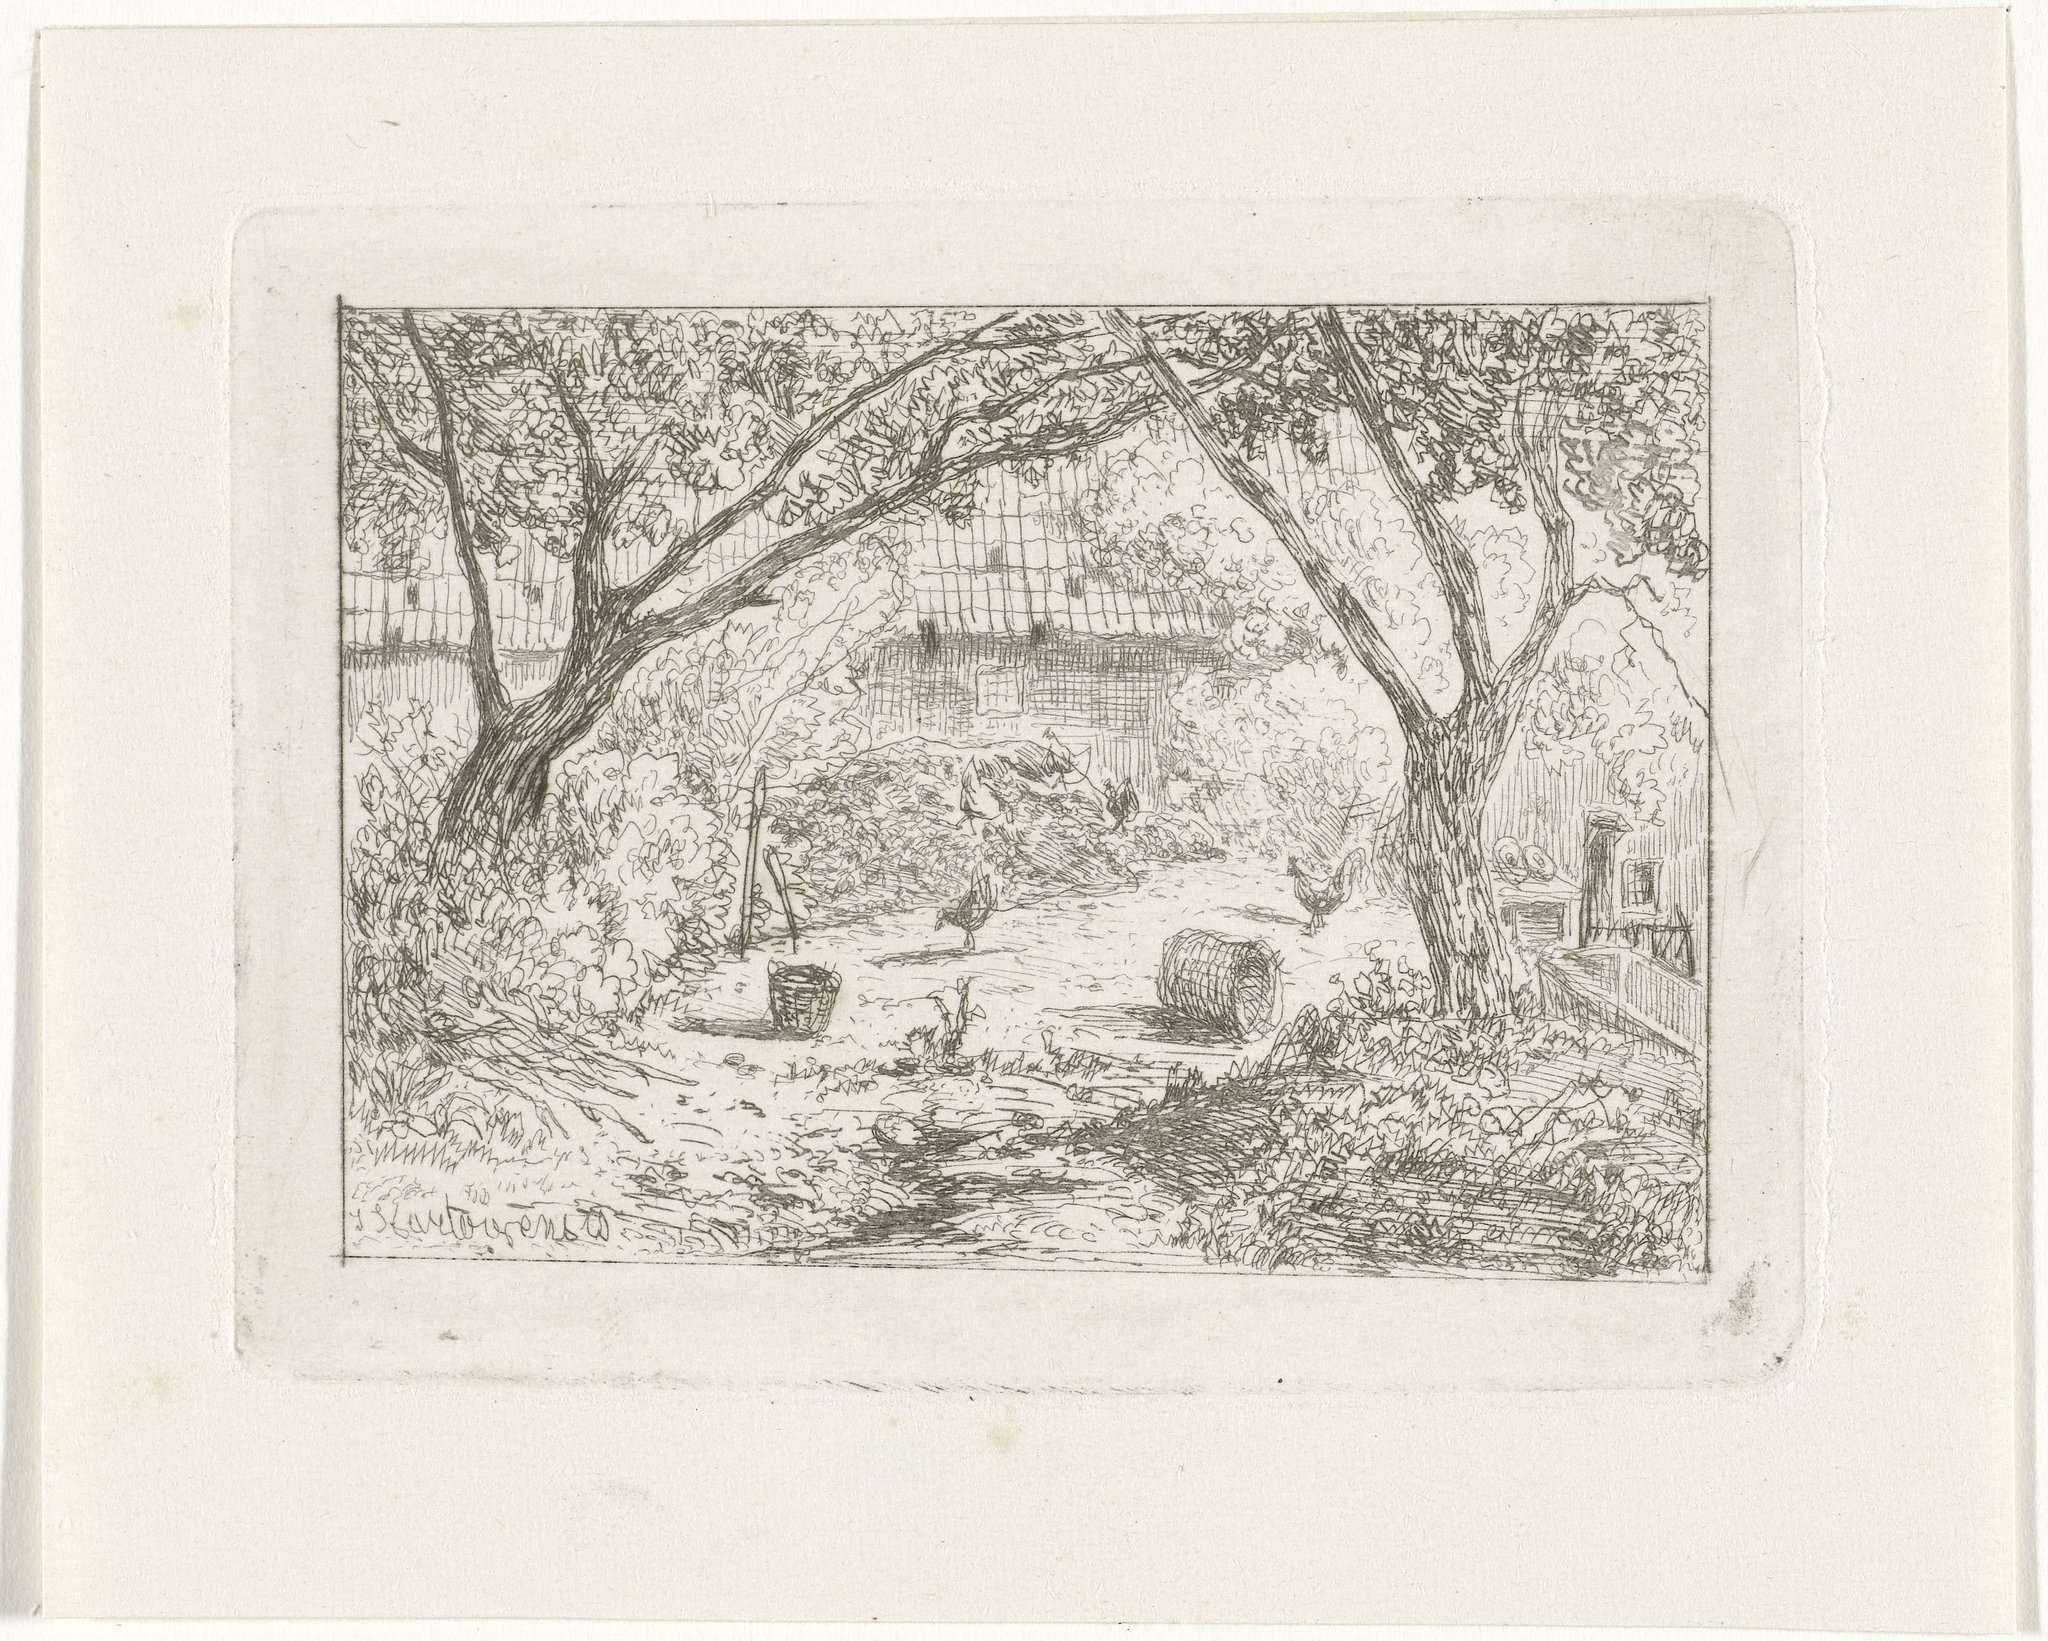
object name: print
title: Boerenerf met kippen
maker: joseph hartogensis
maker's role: painter, print maker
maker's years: 1822-1865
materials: paper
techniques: etching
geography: the hague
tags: fowl (cock, hen, chicken, etc.), farm (building)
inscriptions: collector's mark: Lugt 2228